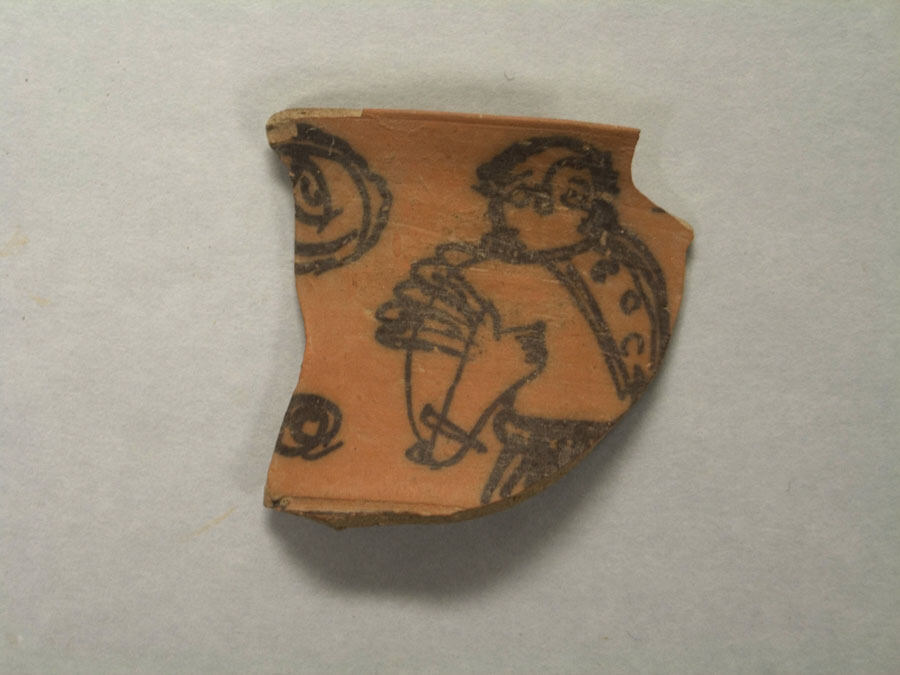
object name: shard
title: Shard with Figural Decoration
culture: pakistani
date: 301-500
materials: terracotta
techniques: painting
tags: human figures,gandhara